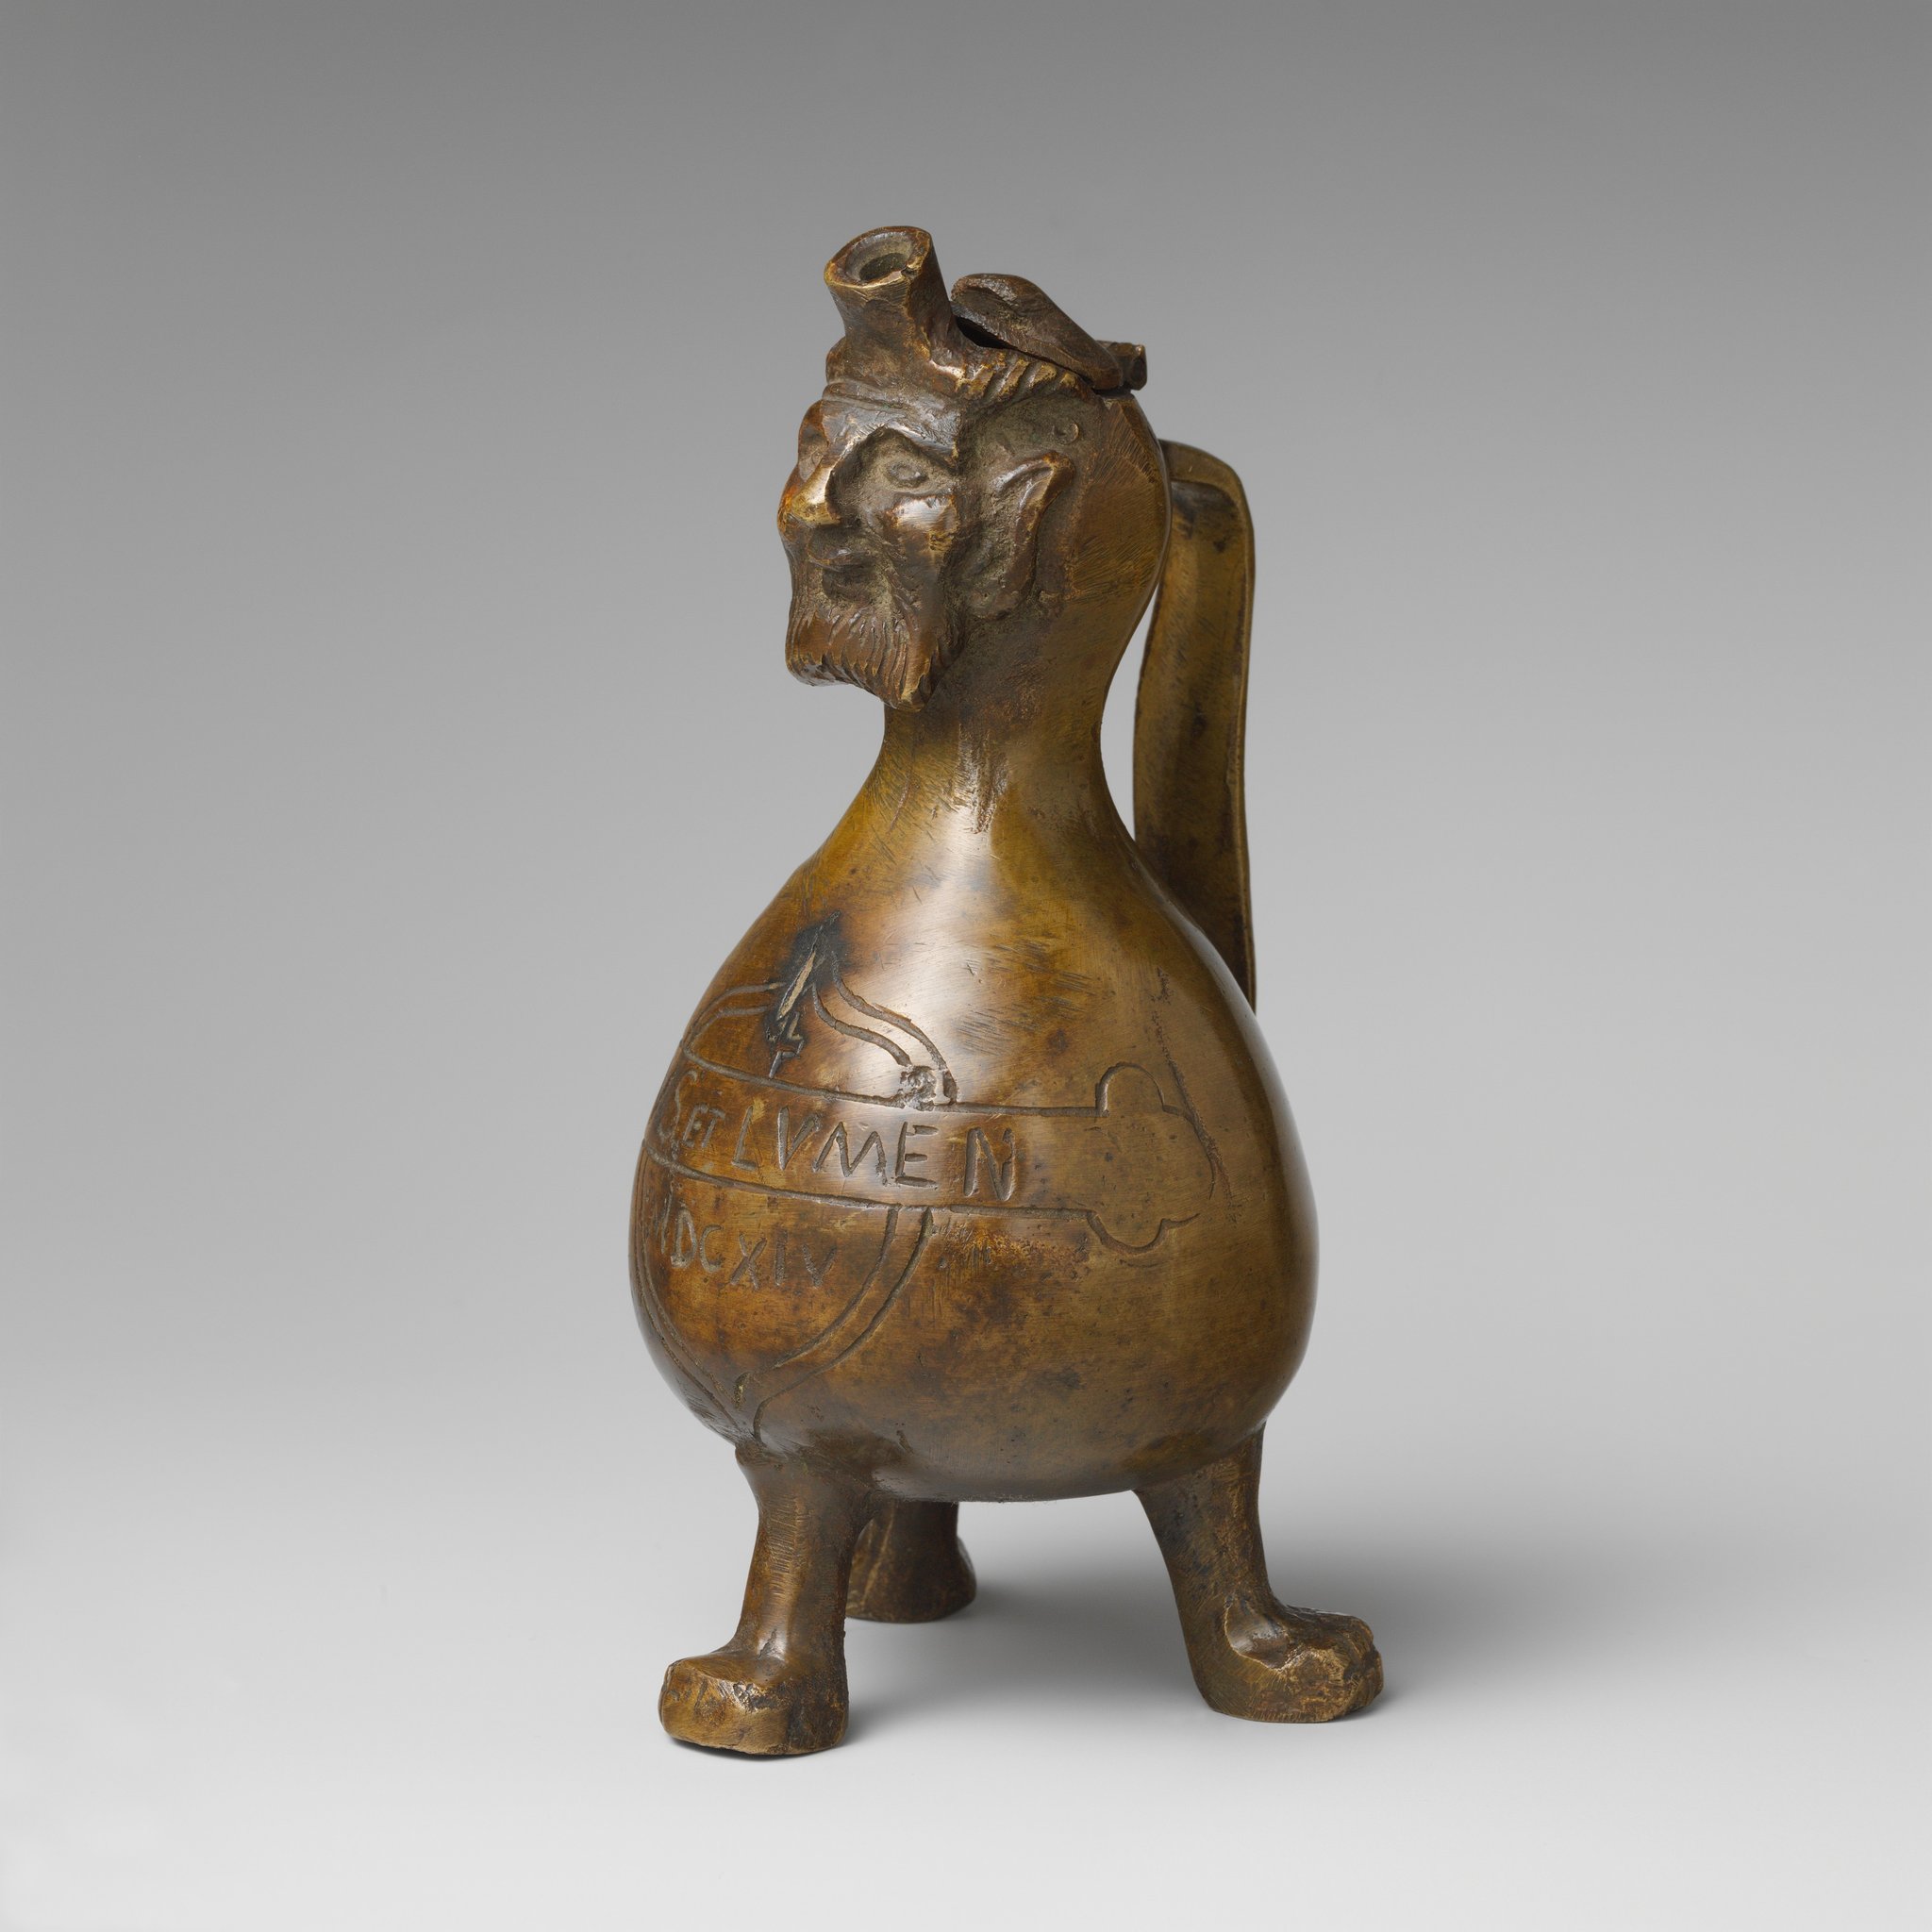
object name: aquamanile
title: Aquamanile in the Form of a Gourd with a Human Head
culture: german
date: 1801-1900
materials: bronze, copper alloy, patina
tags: heads